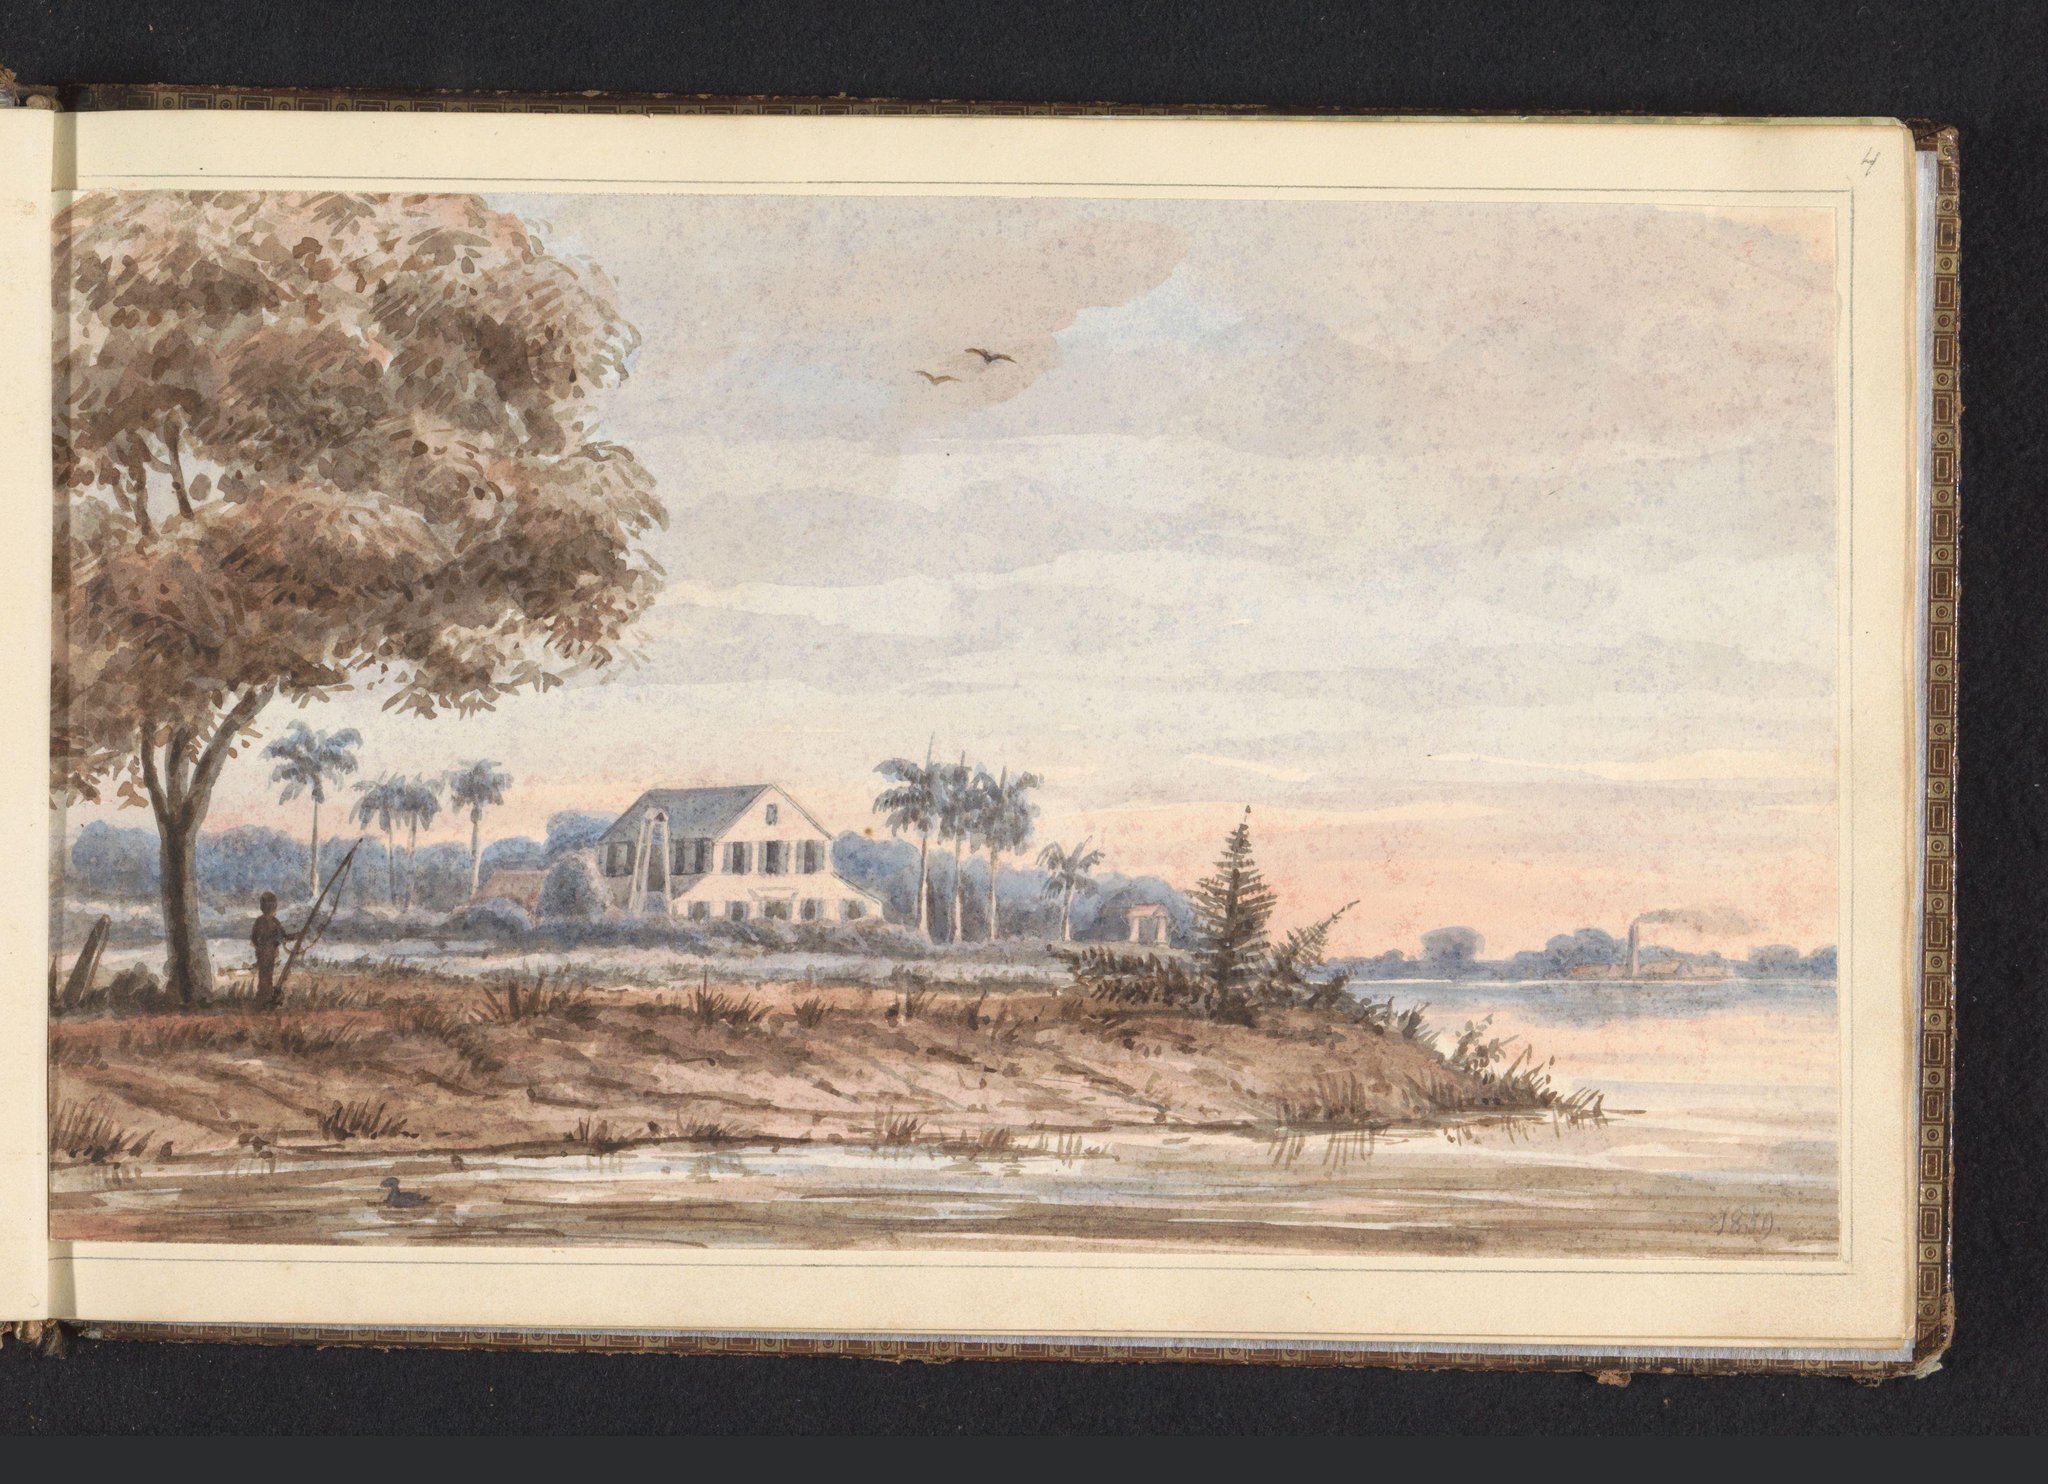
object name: album leaf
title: Album met tekeningen van Suriname, p.4 (50)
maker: jacob marius adriaan martini van geffen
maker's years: 1821-1866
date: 1859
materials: ink, paper, pencil, watercolor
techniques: brush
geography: suriname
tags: suriname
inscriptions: signature and date: ‘gedateerd recto r.o.:1859’